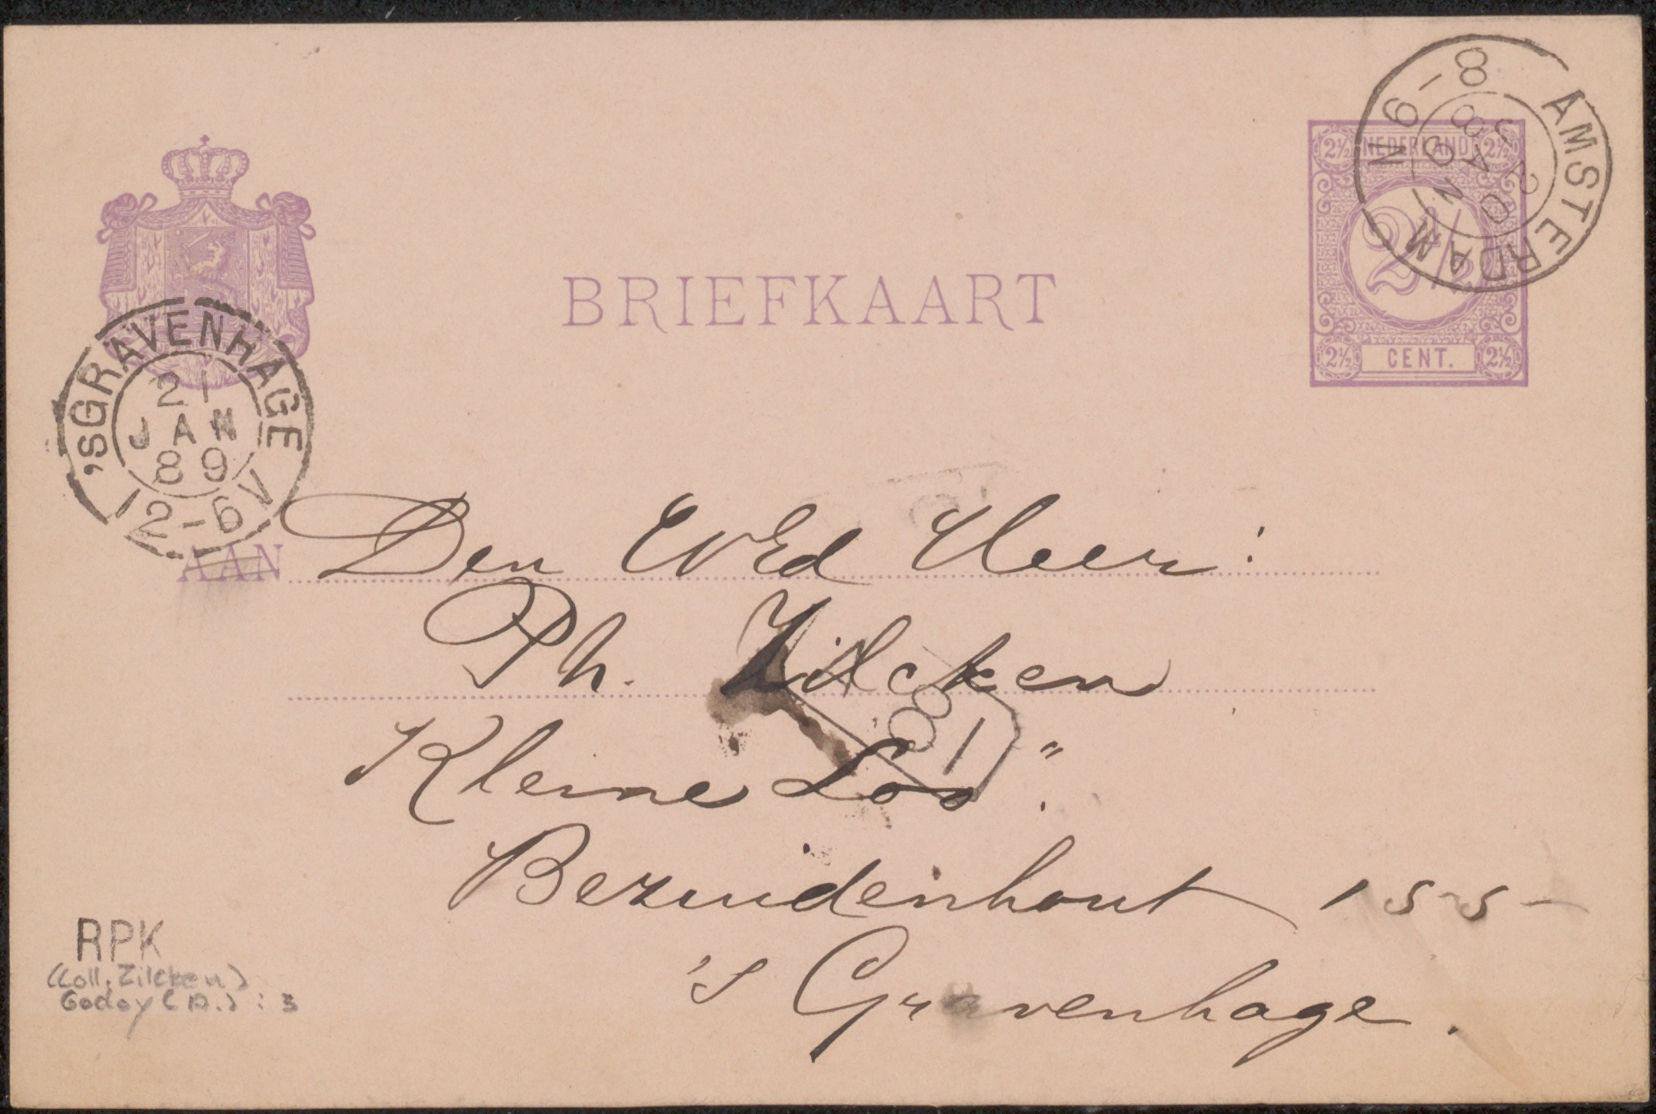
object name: postcard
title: Briefkaart aan Philip Zilcken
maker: adèle josephine godoy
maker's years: 1863-1918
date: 1889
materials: cardboard, ink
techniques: pen, writing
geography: amsterdam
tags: the hague, painter, draughtsman, philip zilcken, literature ~ arts, sending and receiving postal matter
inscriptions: collector's mark: ‘RPK’